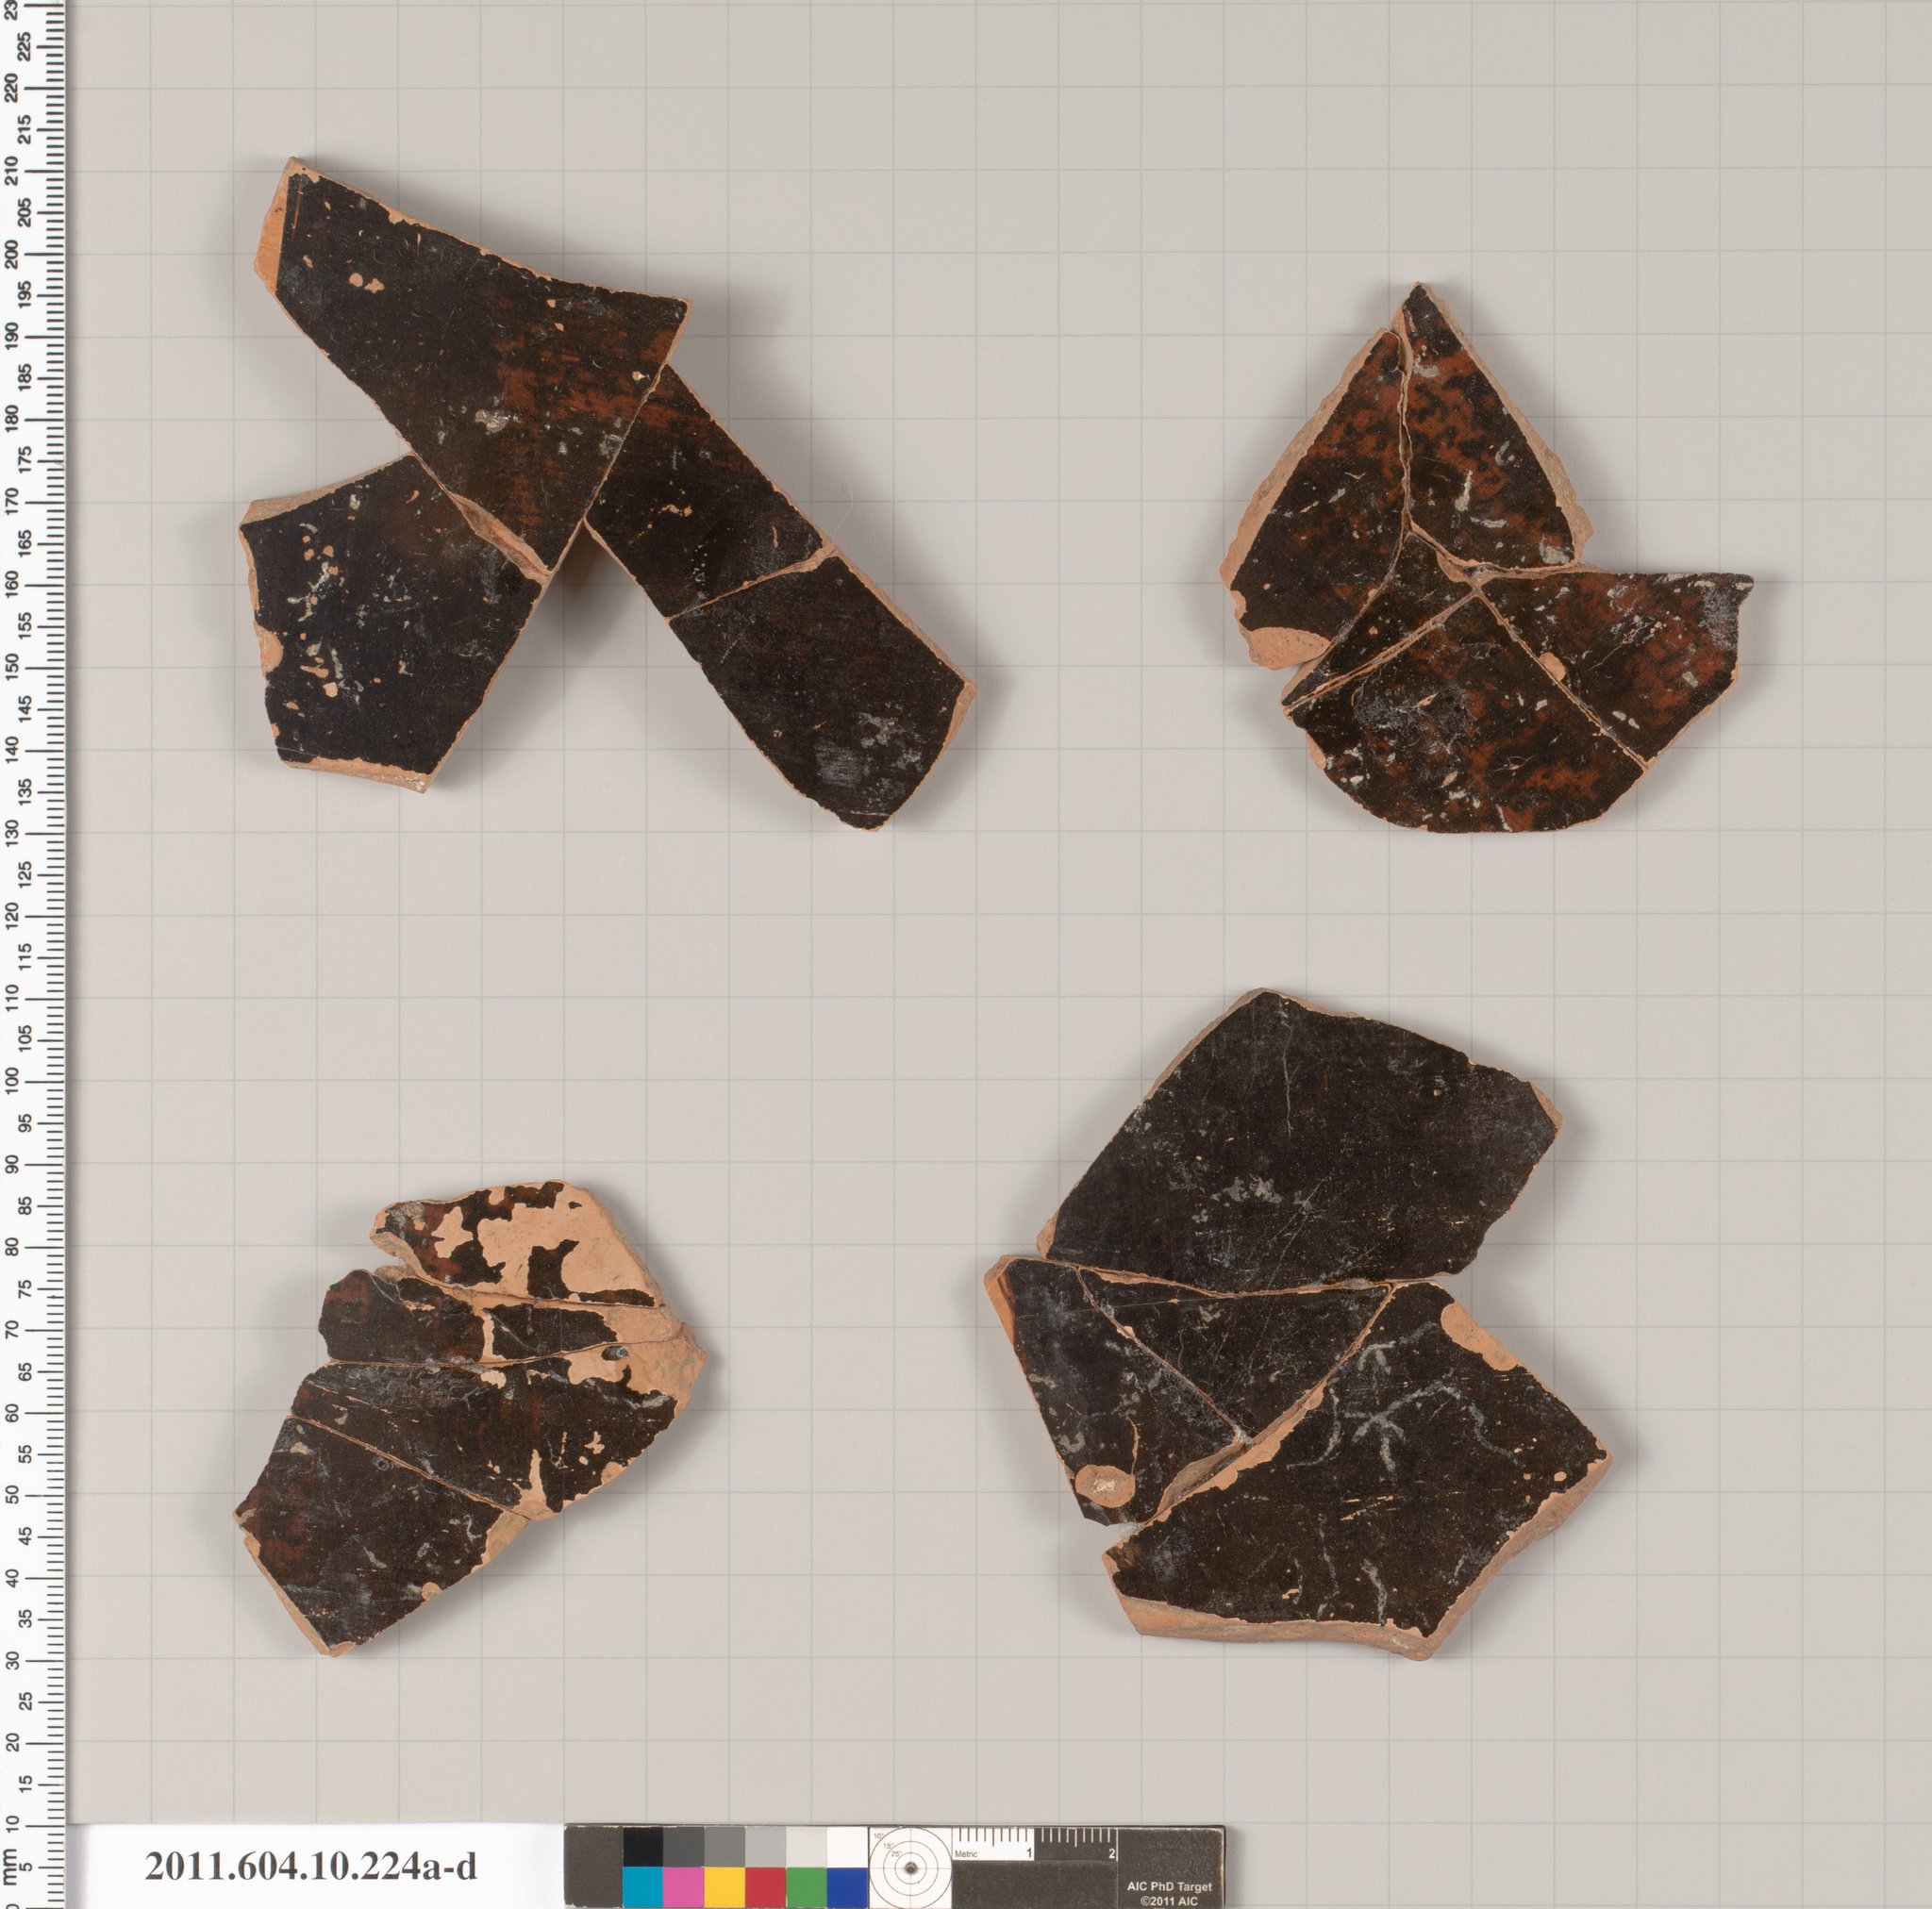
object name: undetermined closed shape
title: Terracotta fragments of a closed shape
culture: etruscan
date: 601-700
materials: terracotta